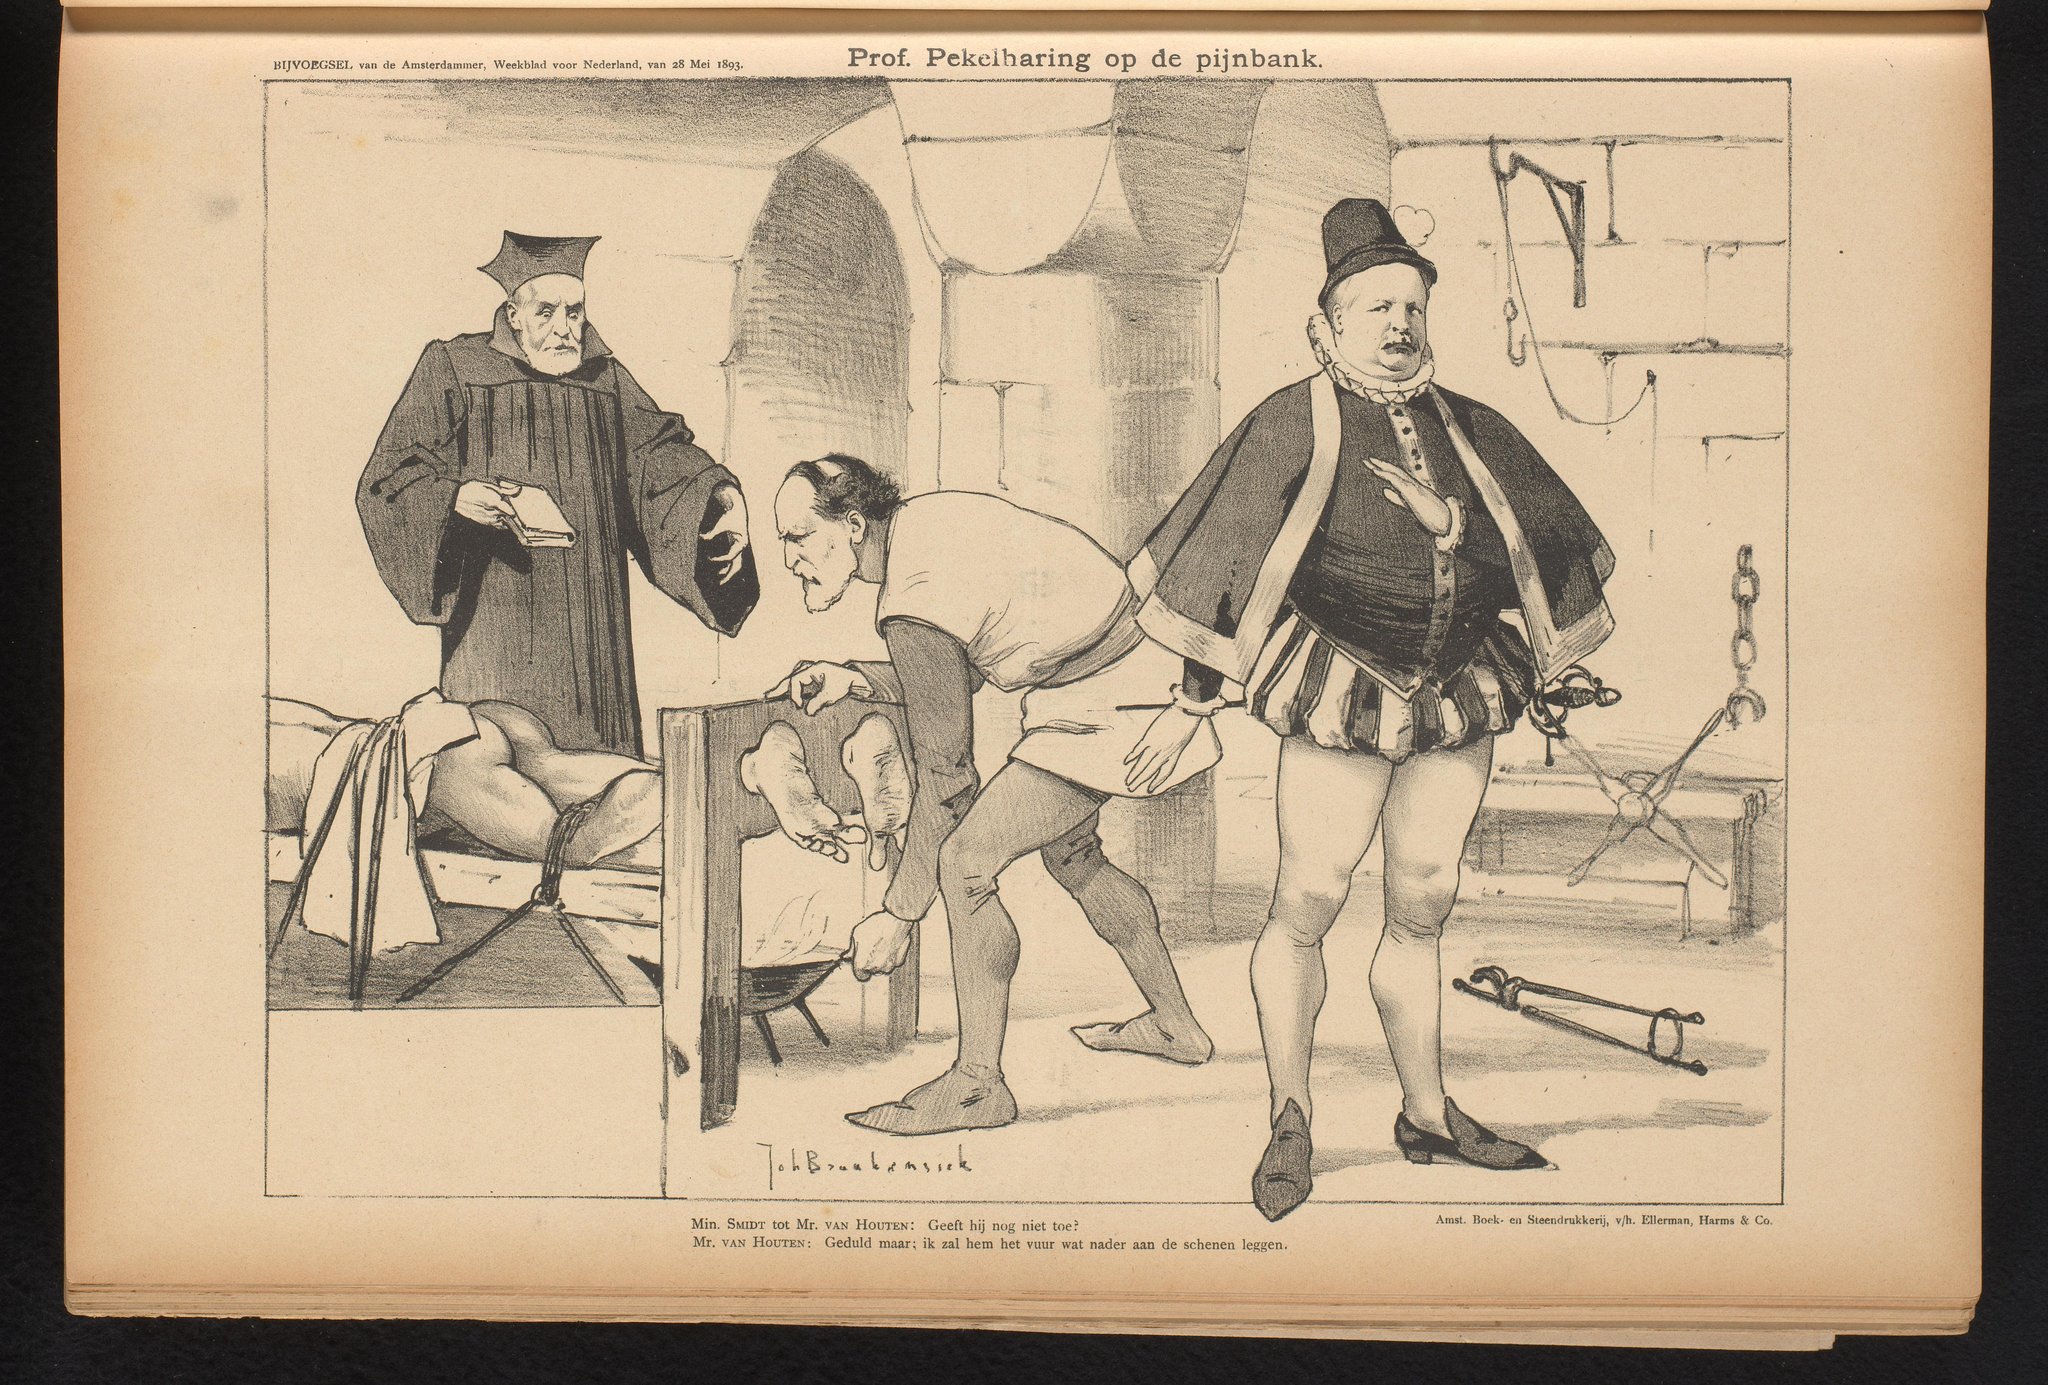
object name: cartoon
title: Prof. Pekelharing op de pijnbank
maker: johan braakensiek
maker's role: draughtsman, print maker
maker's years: 1858-1940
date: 1893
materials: paper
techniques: lithograph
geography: amsterdam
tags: the hague, politician, samuel van houten, instruments of torture, execution or punishment: rack, inquisitor, political caricatures and satires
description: Hoogleraar Baltus Hendrik Pekelharing door Samuel van Houten op de pijnbank gelegd. Minister van Justitie Hendrik Jan Smidt ziet als katholieke inquisiteur toe terwijl minister van Binnenlandse Zaken Tak van Poortvliet zich van het schouwspel afwendt.